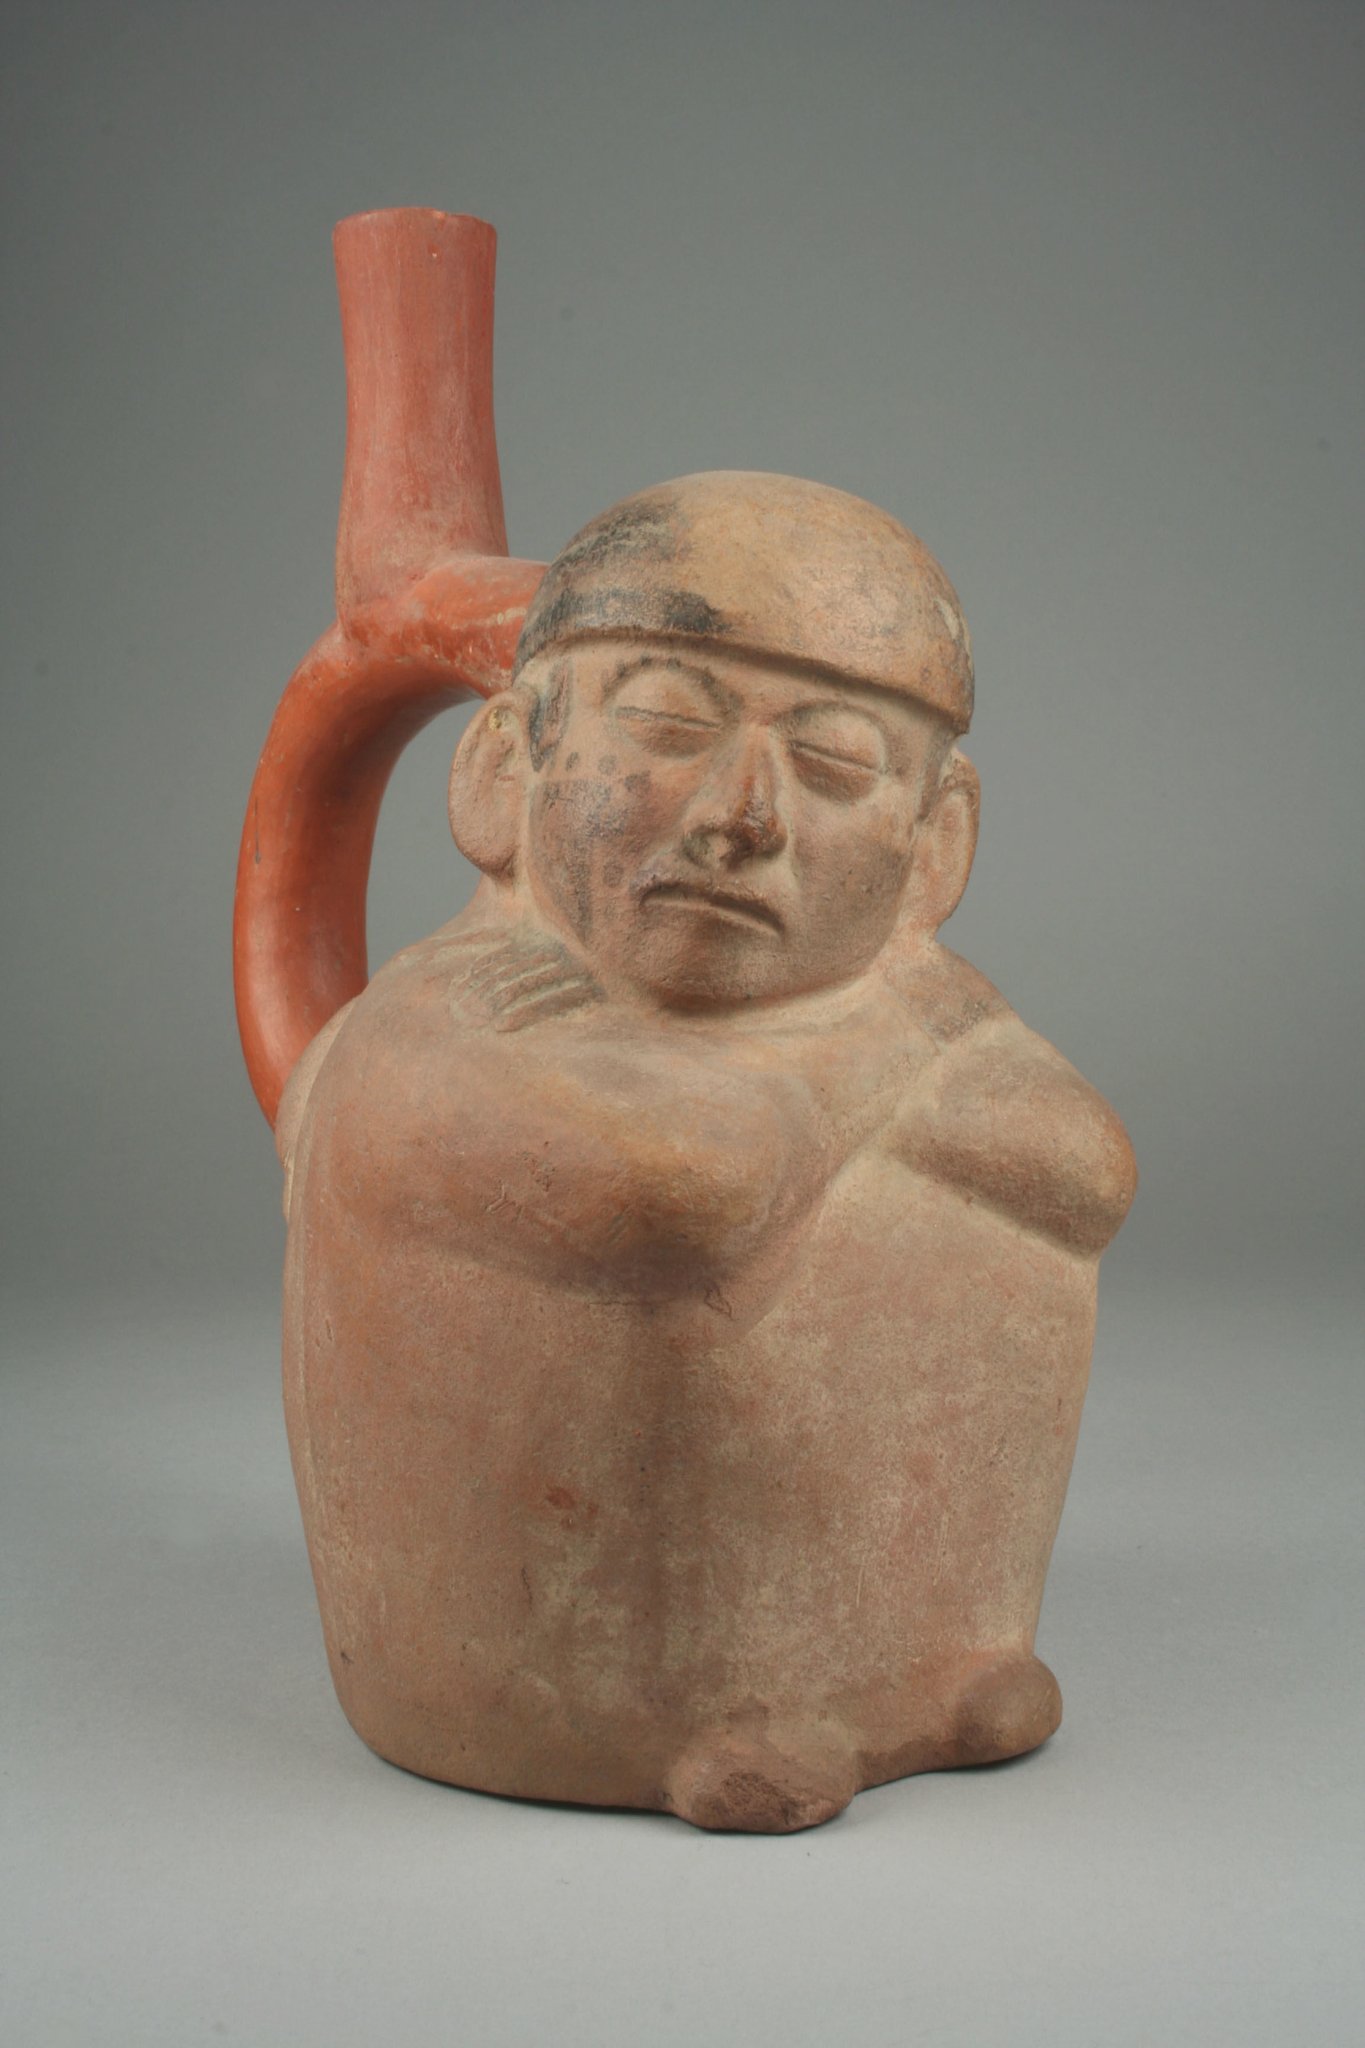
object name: bottle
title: Bottle, Sleeping Figure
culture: moche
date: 201-600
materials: ceramic, pigment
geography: peru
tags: sleeping,men